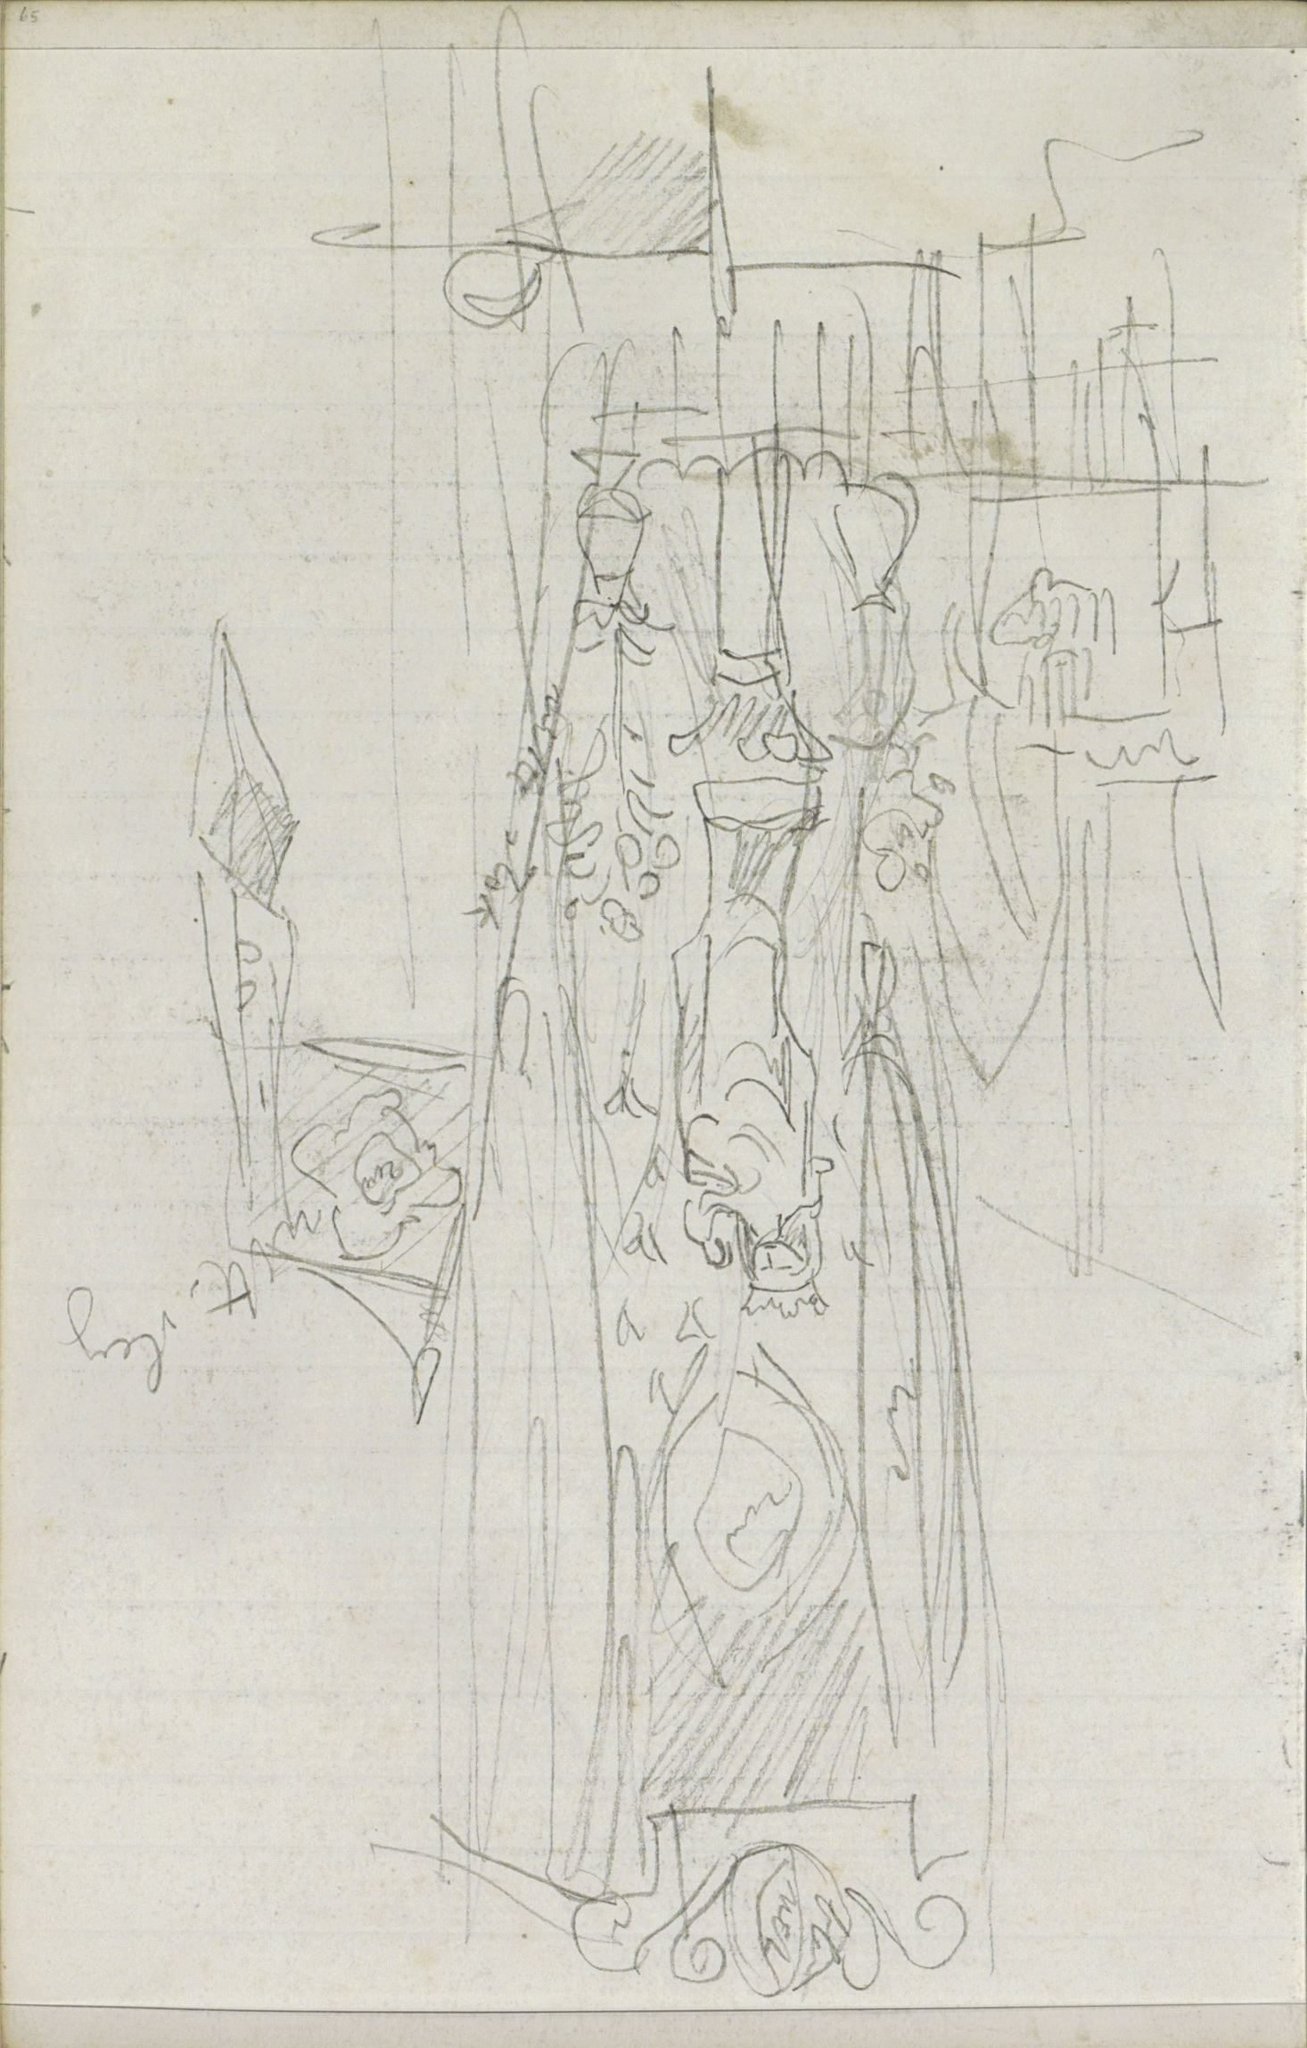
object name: sketchbook leaf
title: Beeld van de gekroonde Maagd Maria met Christus op de arm in de Notre-Dame, Parijs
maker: marius bauer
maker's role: draughtsman, print maker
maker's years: 1867-1932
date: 1877-1932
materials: pencil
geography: paris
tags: christ-child sitting on mary's shoulder, interior of church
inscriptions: kleurnotitie, handgeschreven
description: Pagina 65 uit een schetsboek met 68 bladen.